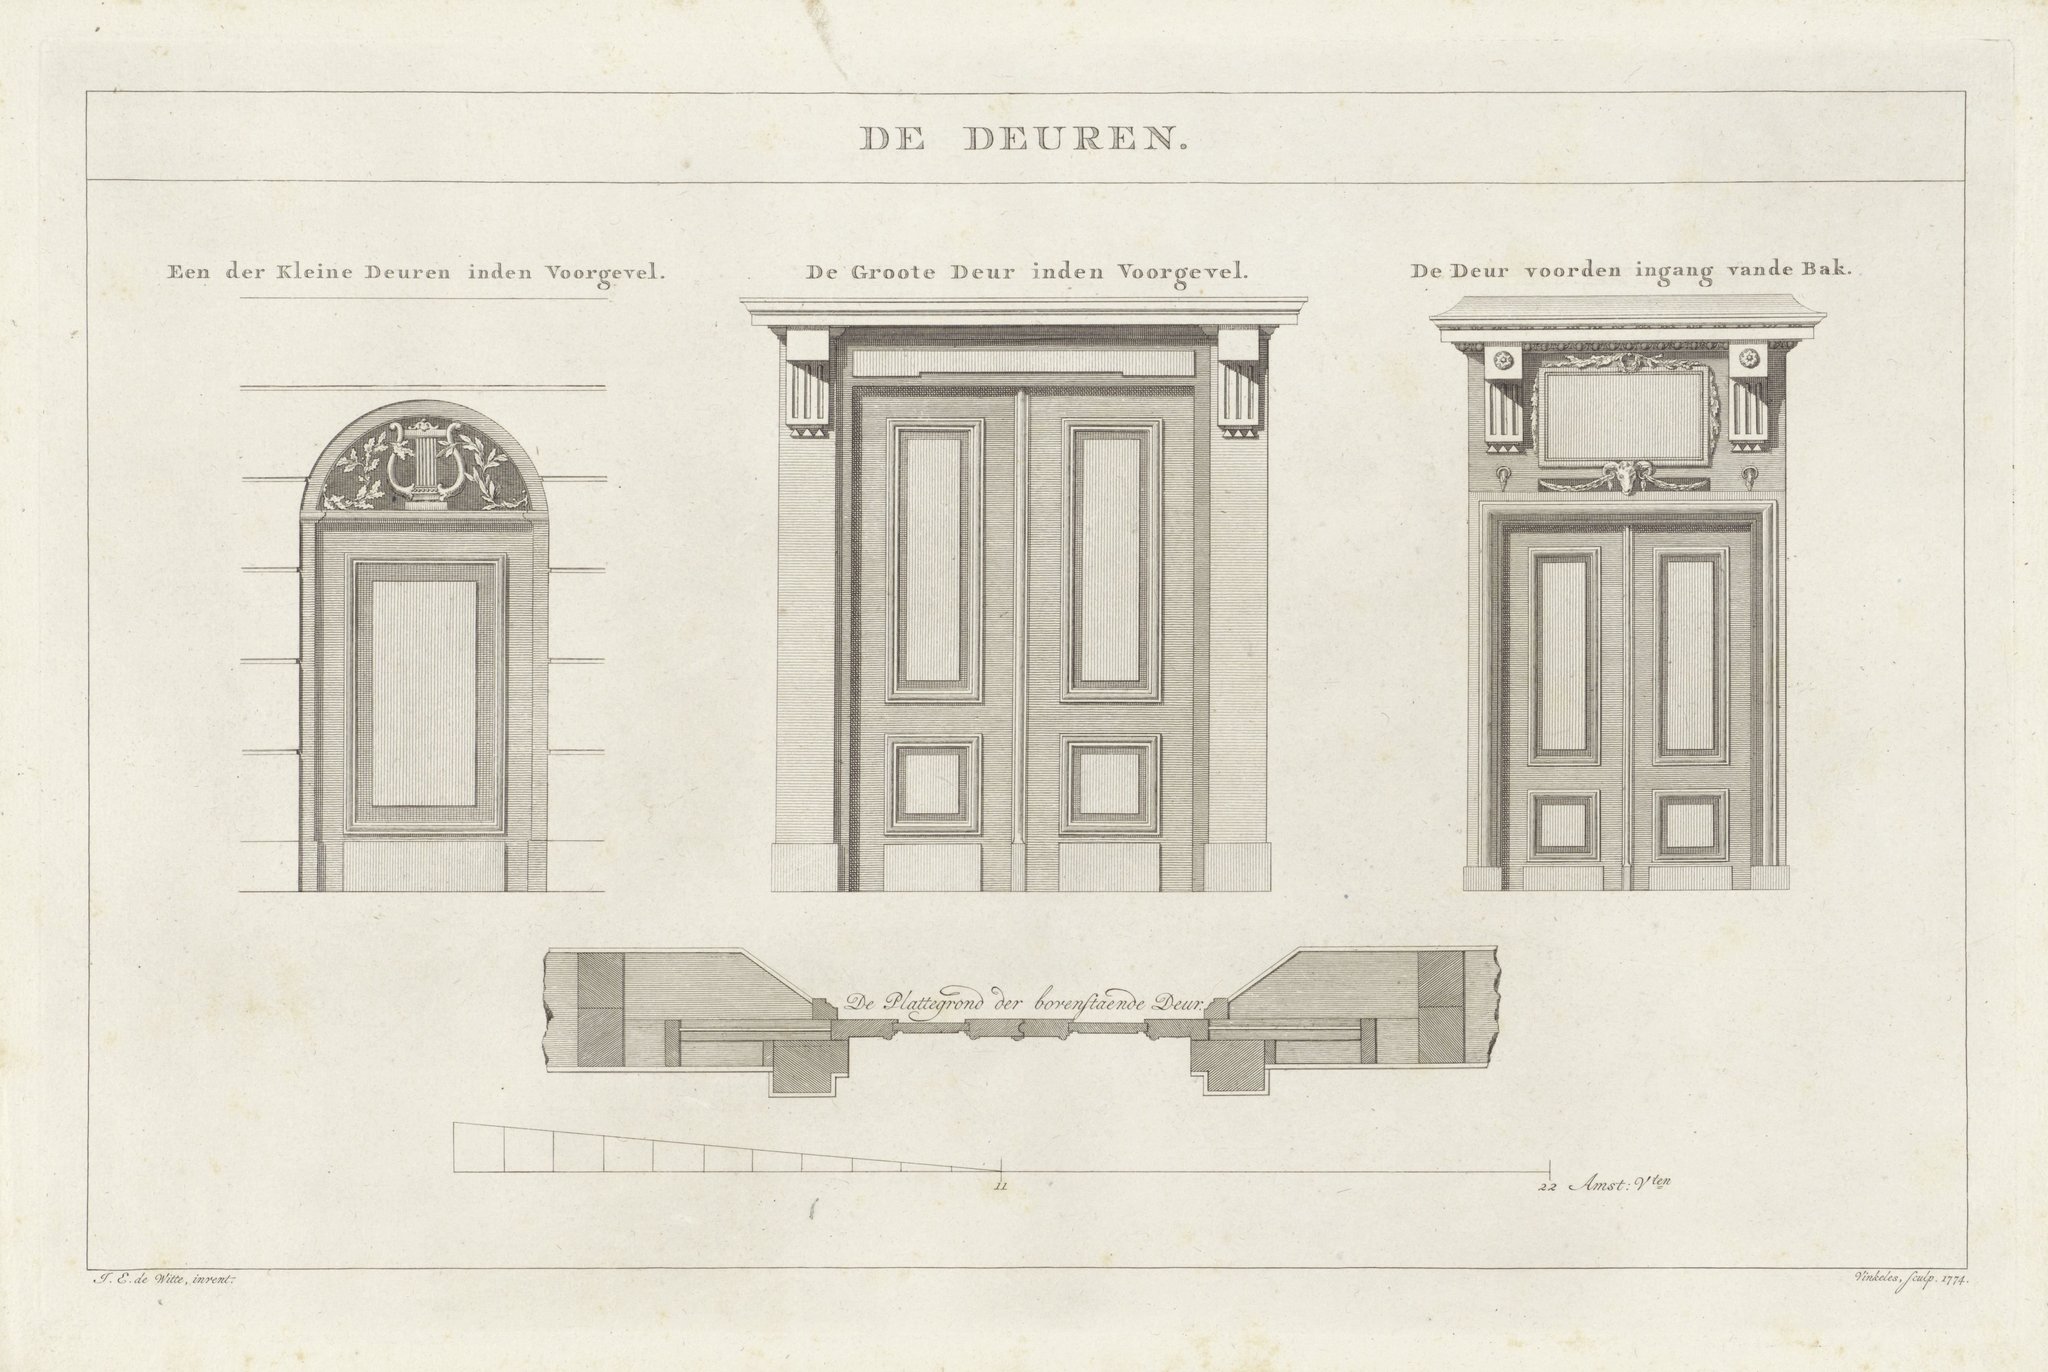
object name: print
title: De deuren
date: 1774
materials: paper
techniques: etching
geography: amsterdam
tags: theatre (building), amsterdam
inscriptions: collector's mark: Lugt 2228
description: Illustratie voor: Witte, Jacob Eduard de. Afbeeldingen van den schouwburg te Amsterdam. Amsterdam: Johannes Smit, 1774.